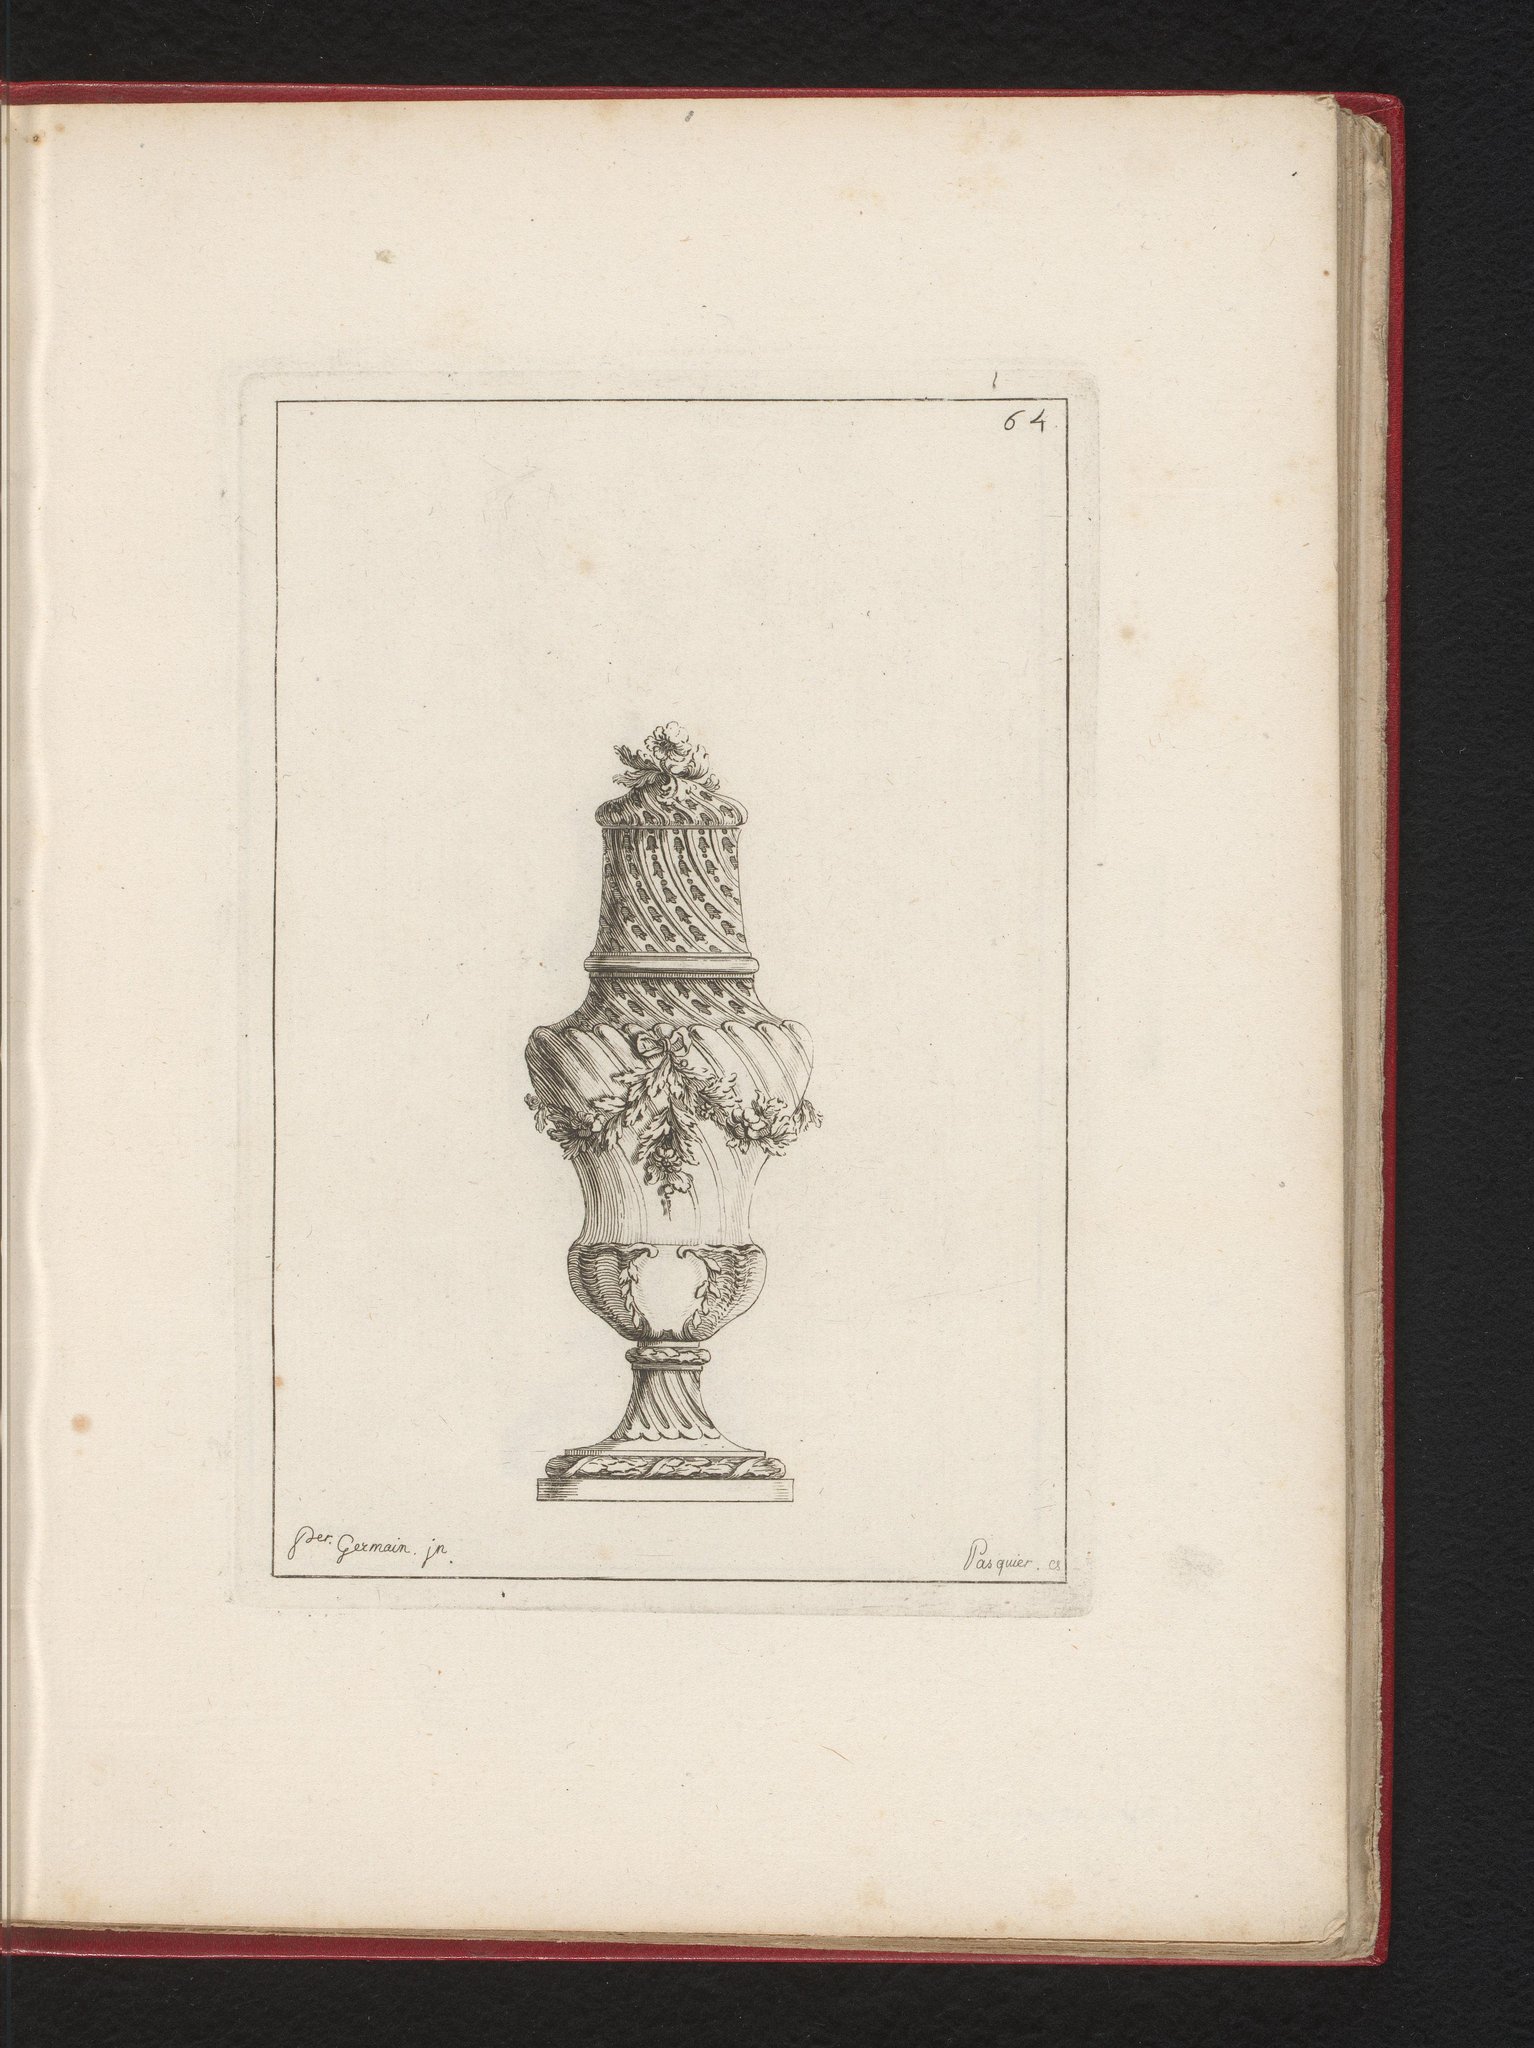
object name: album leaf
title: Zilverwerk en edelsmeedkunst, tweede deel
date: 1748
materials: paper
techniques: etching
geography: paris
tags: sugar-basin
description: Een aantal van de objecten in deze reeks heeft een eigen ondertitel, die verwijst naar genummerde 'cahiers' (afleveringen) waarin de prenten werden uitgegeven. Het is onduidelijk welke objecten recies bij welke aflevering horen. Daarom is die ondertitel enkel verwerkt bij de prent waarop die voorkomt.